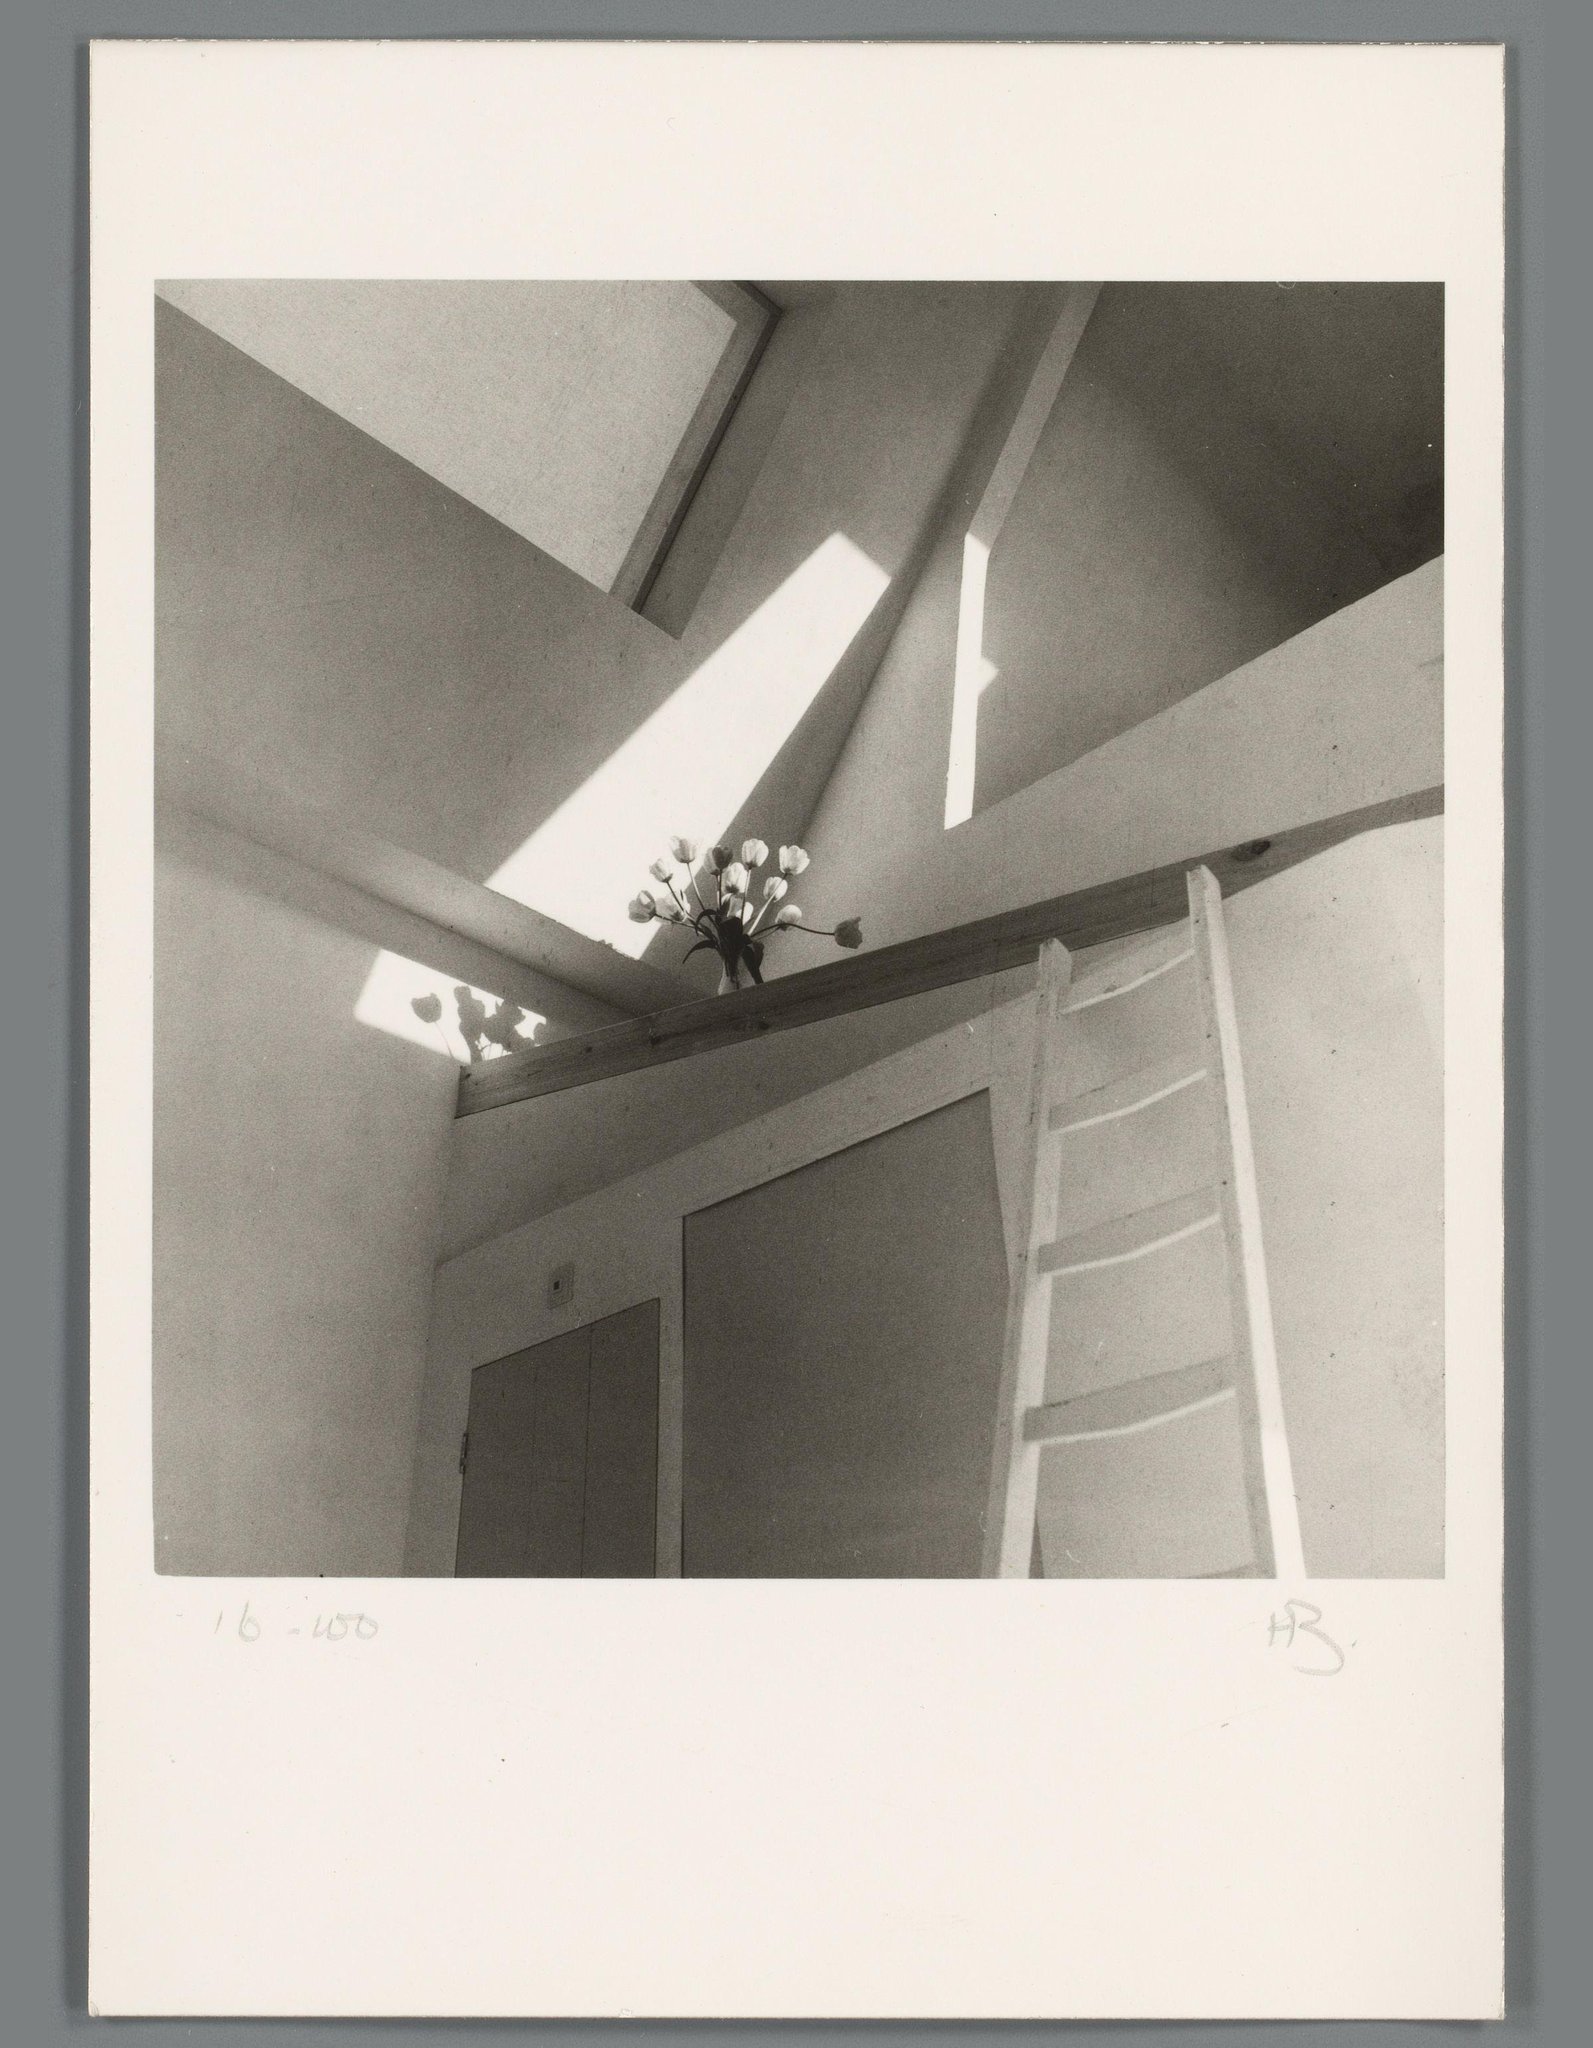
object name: photograph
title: Interieur met vaas met tulpen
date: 1960-1984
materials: paper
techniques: gelatin silver print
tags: flowers: tulip, interior ~ representation of a building